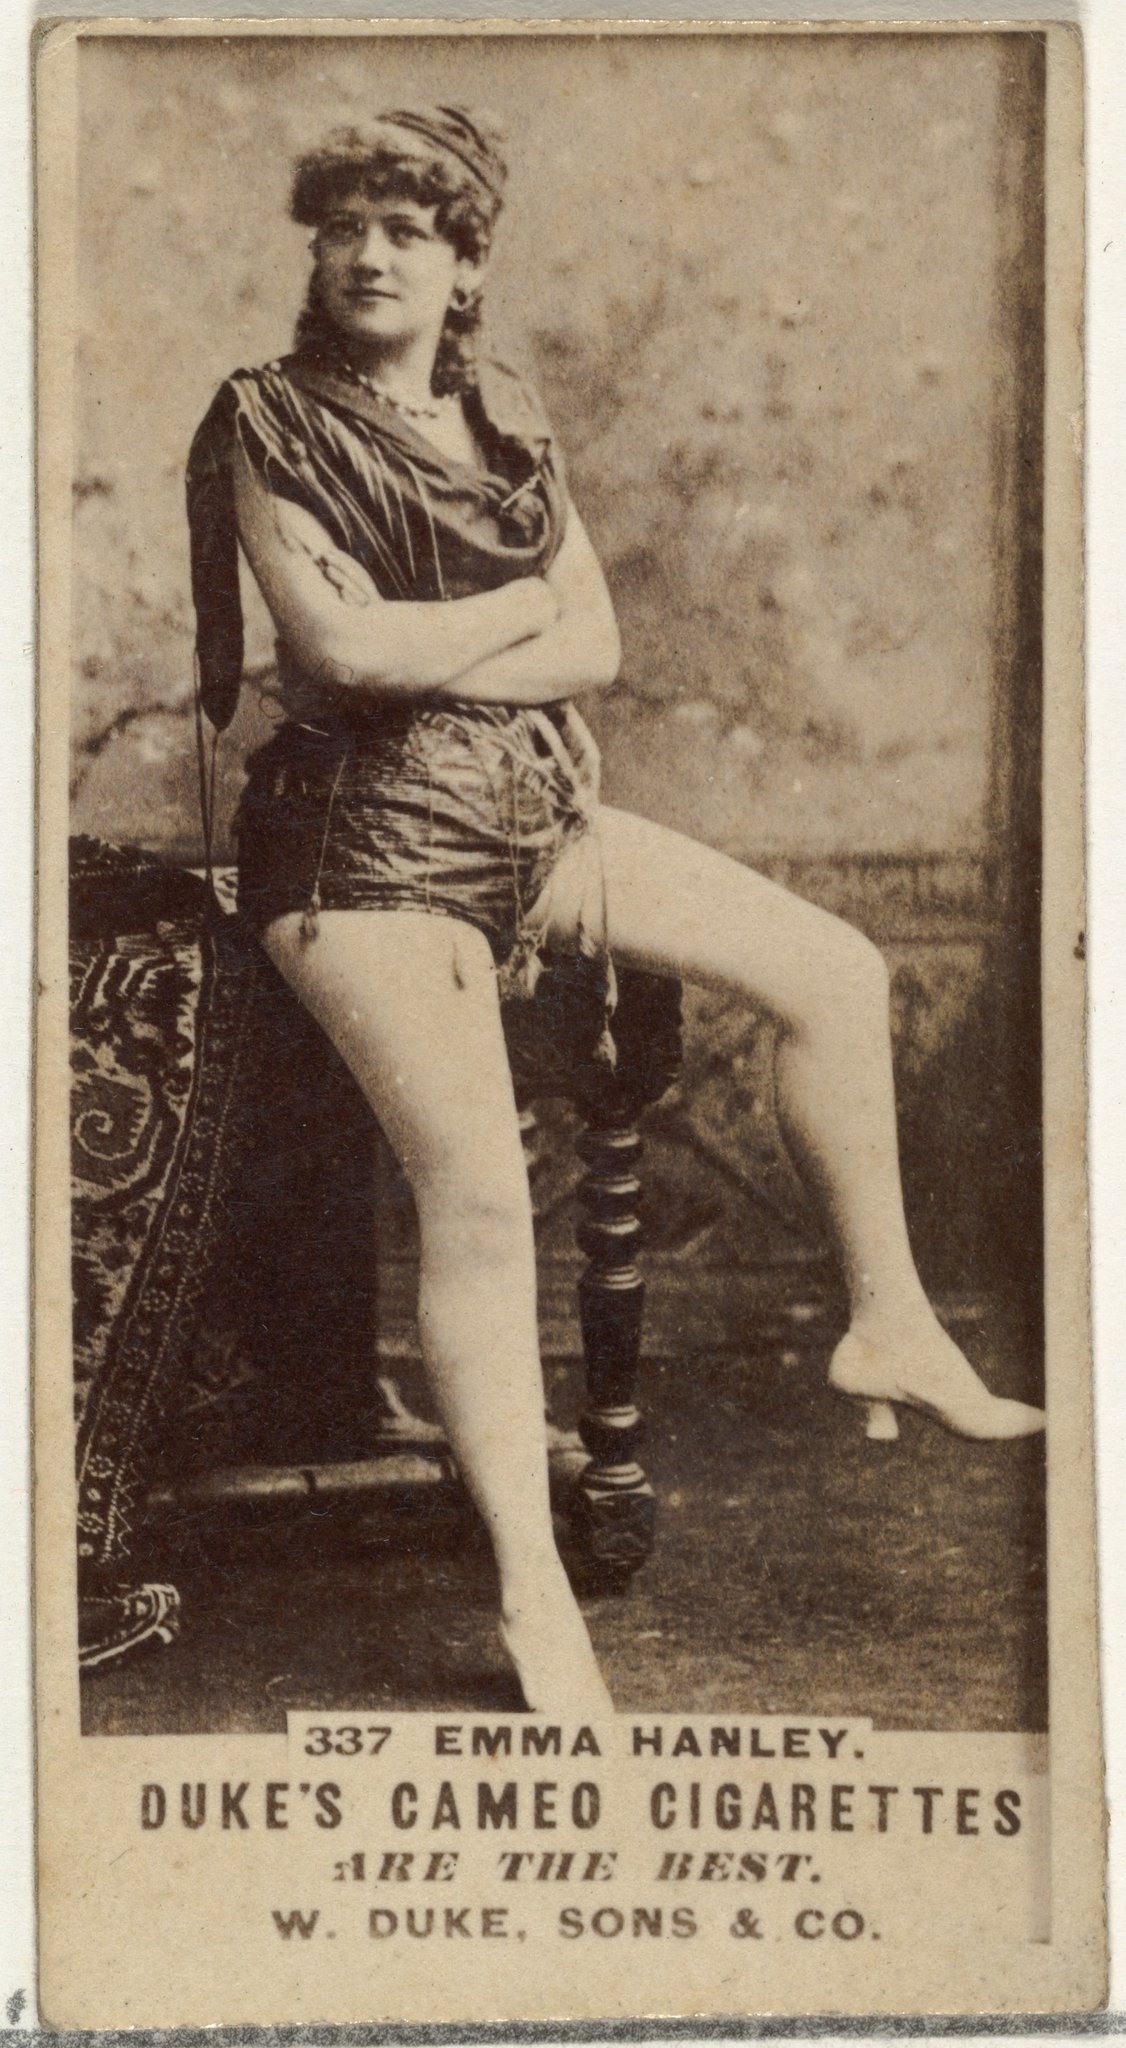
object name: photograph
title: Card Number 337, Emma Hanley, from the Actors and Actresses series (N145-5) issued by Duke Sons & Co. to promote Cameo Cigarettes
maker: w. duke, sons & co.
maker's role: publisher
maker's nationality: american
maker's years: 1870-1920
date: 1880-1889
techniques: albumen silver print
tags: portraits,women,actresses